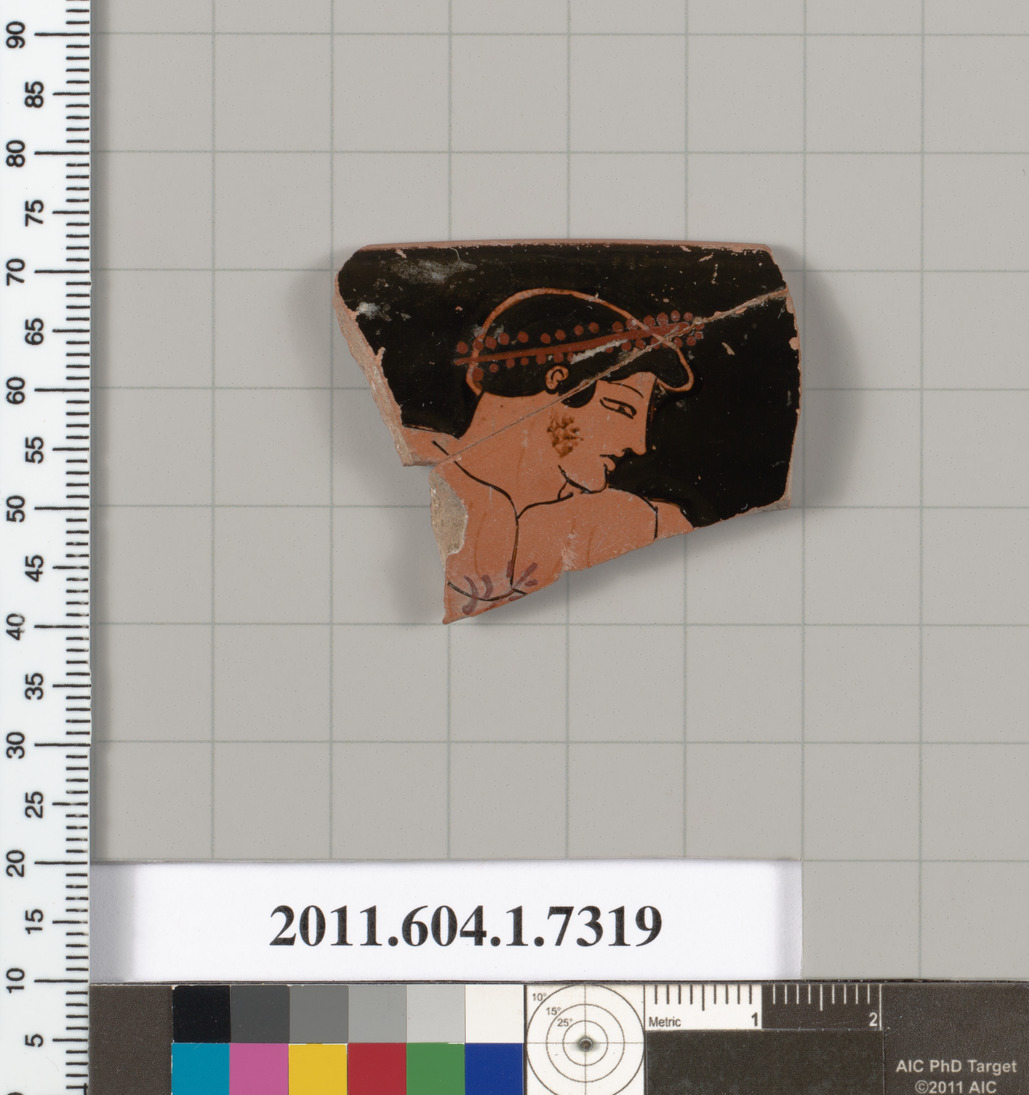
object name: kylix fragment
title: Terracotta rim fragment of a kylix (drinking cup)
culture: greek, attic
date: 500-480 BCE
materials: terracotta